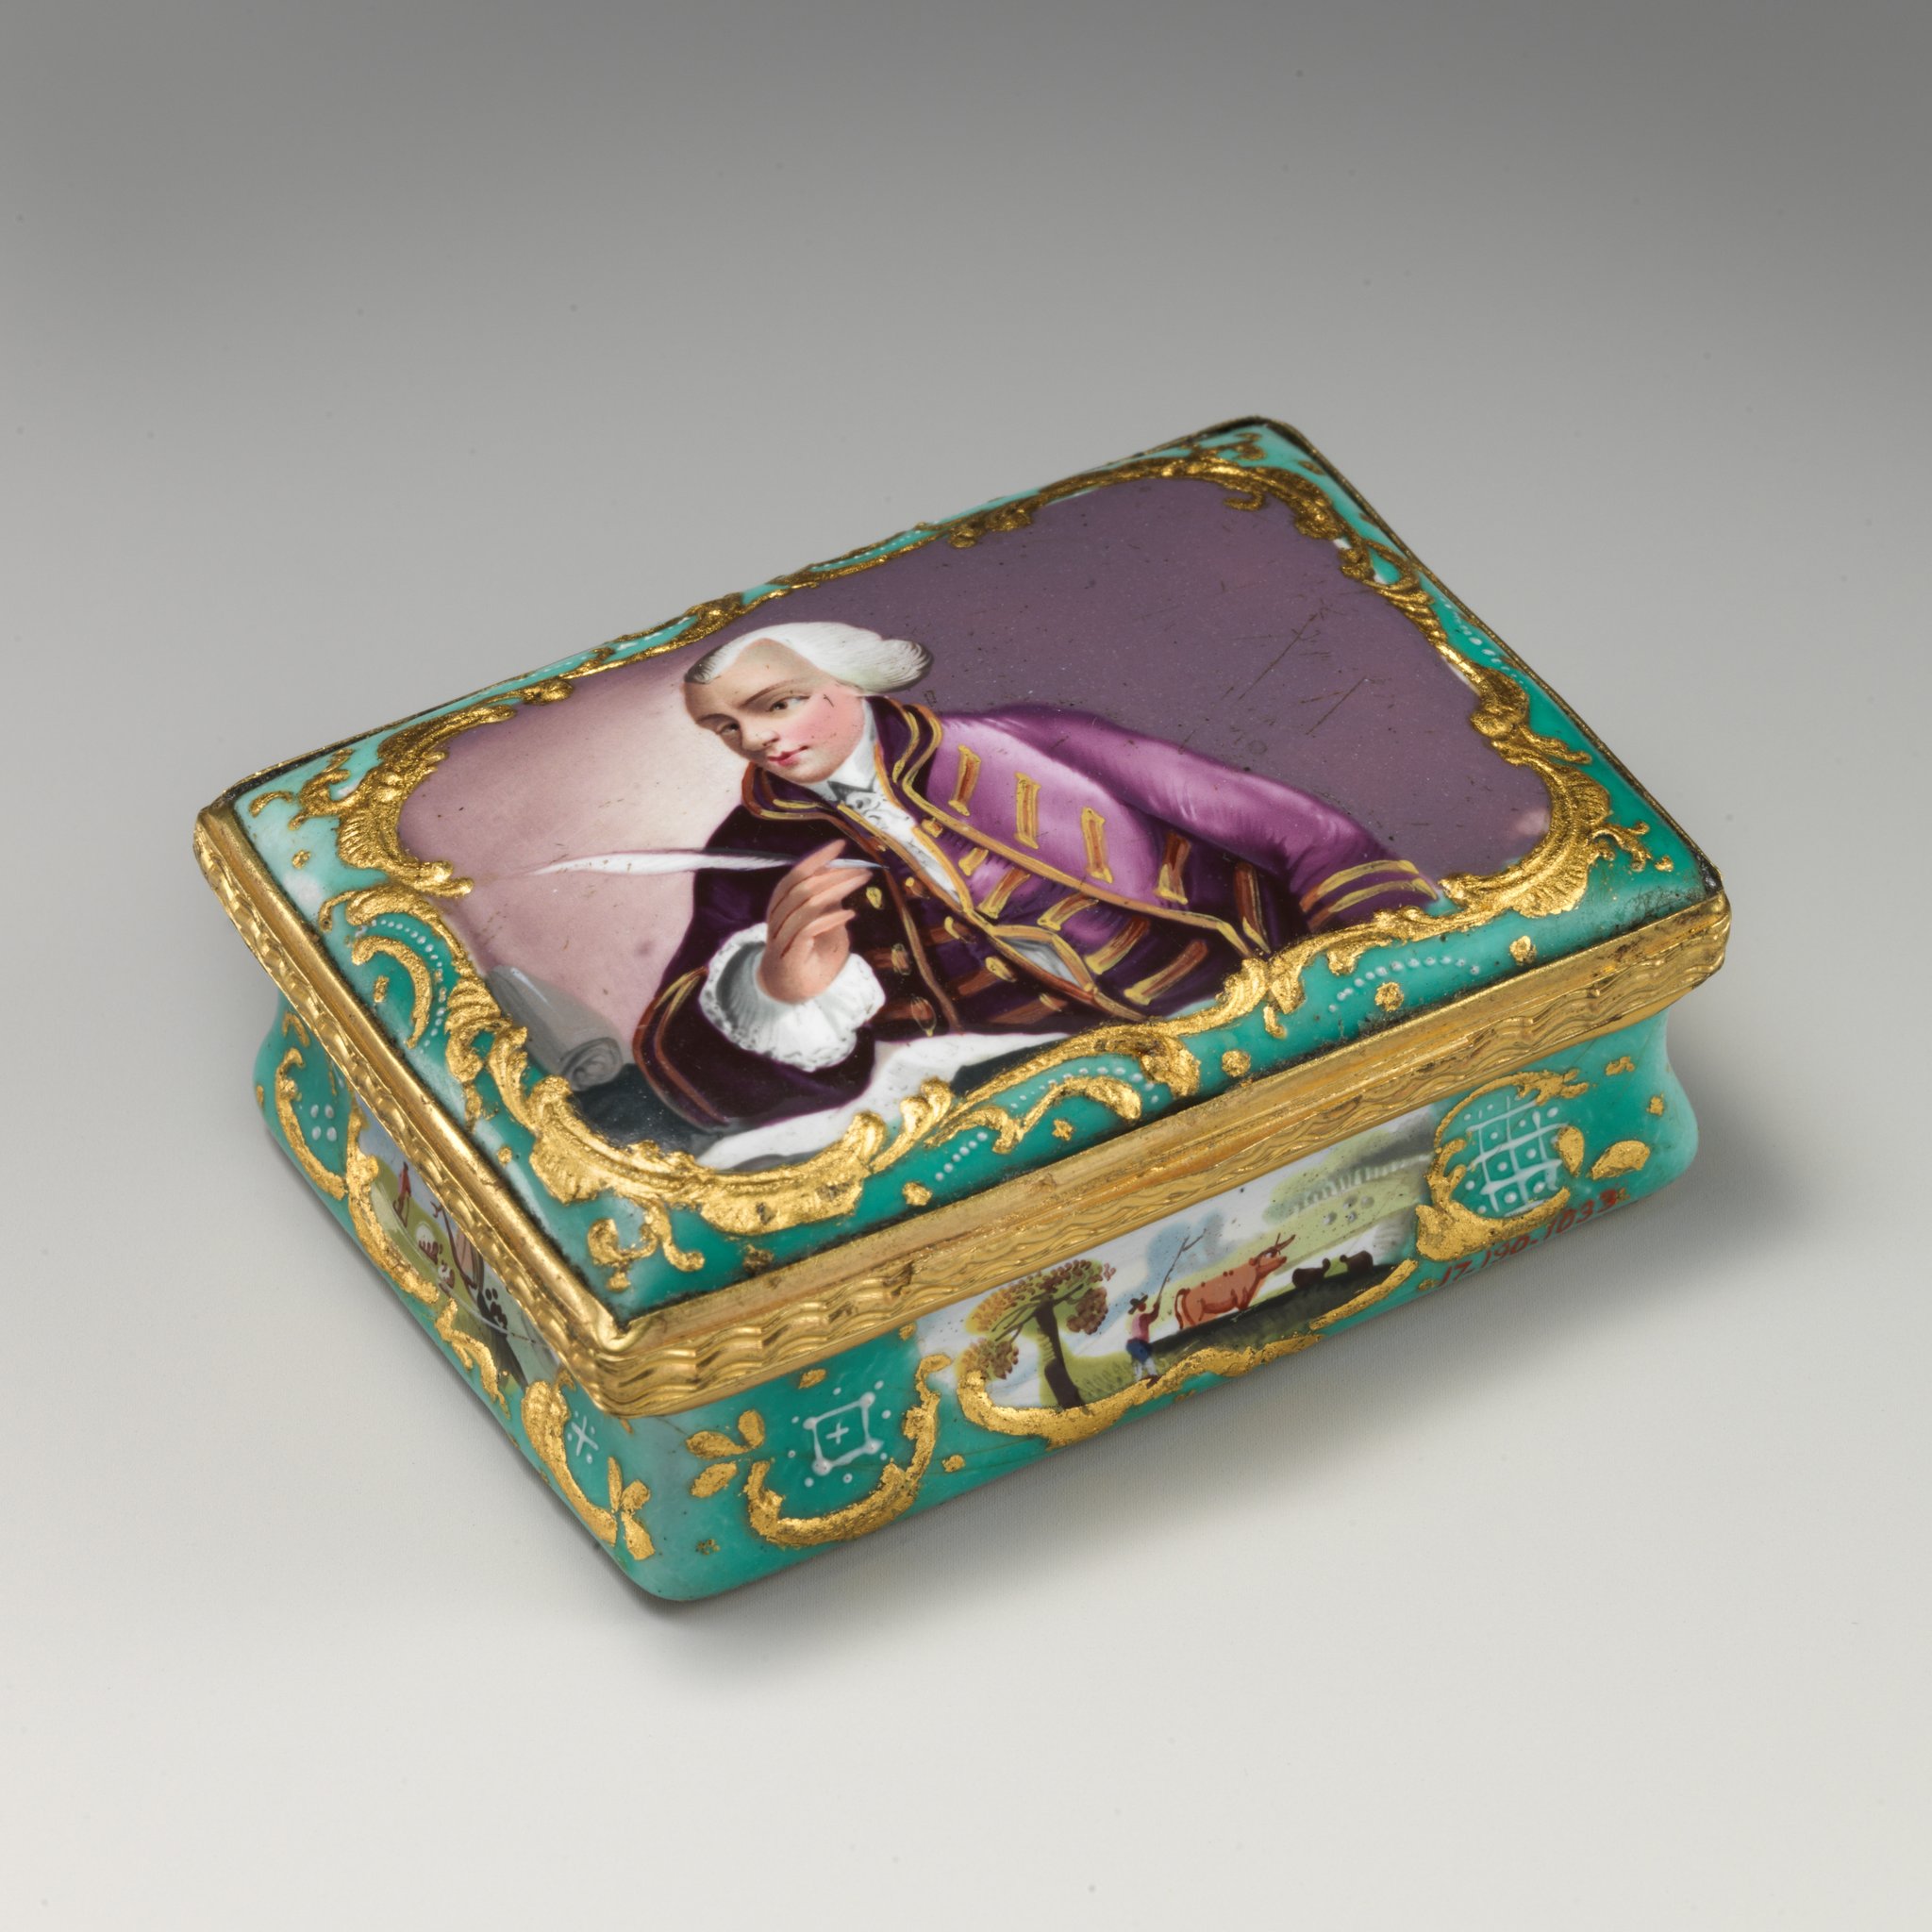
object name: snuffbox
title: Snuffbox with portrait of John Wilkes (1727–1797)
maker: james watson (prentmaker)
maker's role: engraver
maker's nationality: irish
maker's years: 1740-1790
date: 1765-1770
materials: copper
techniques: enamel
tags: animals,men,profiles,trees